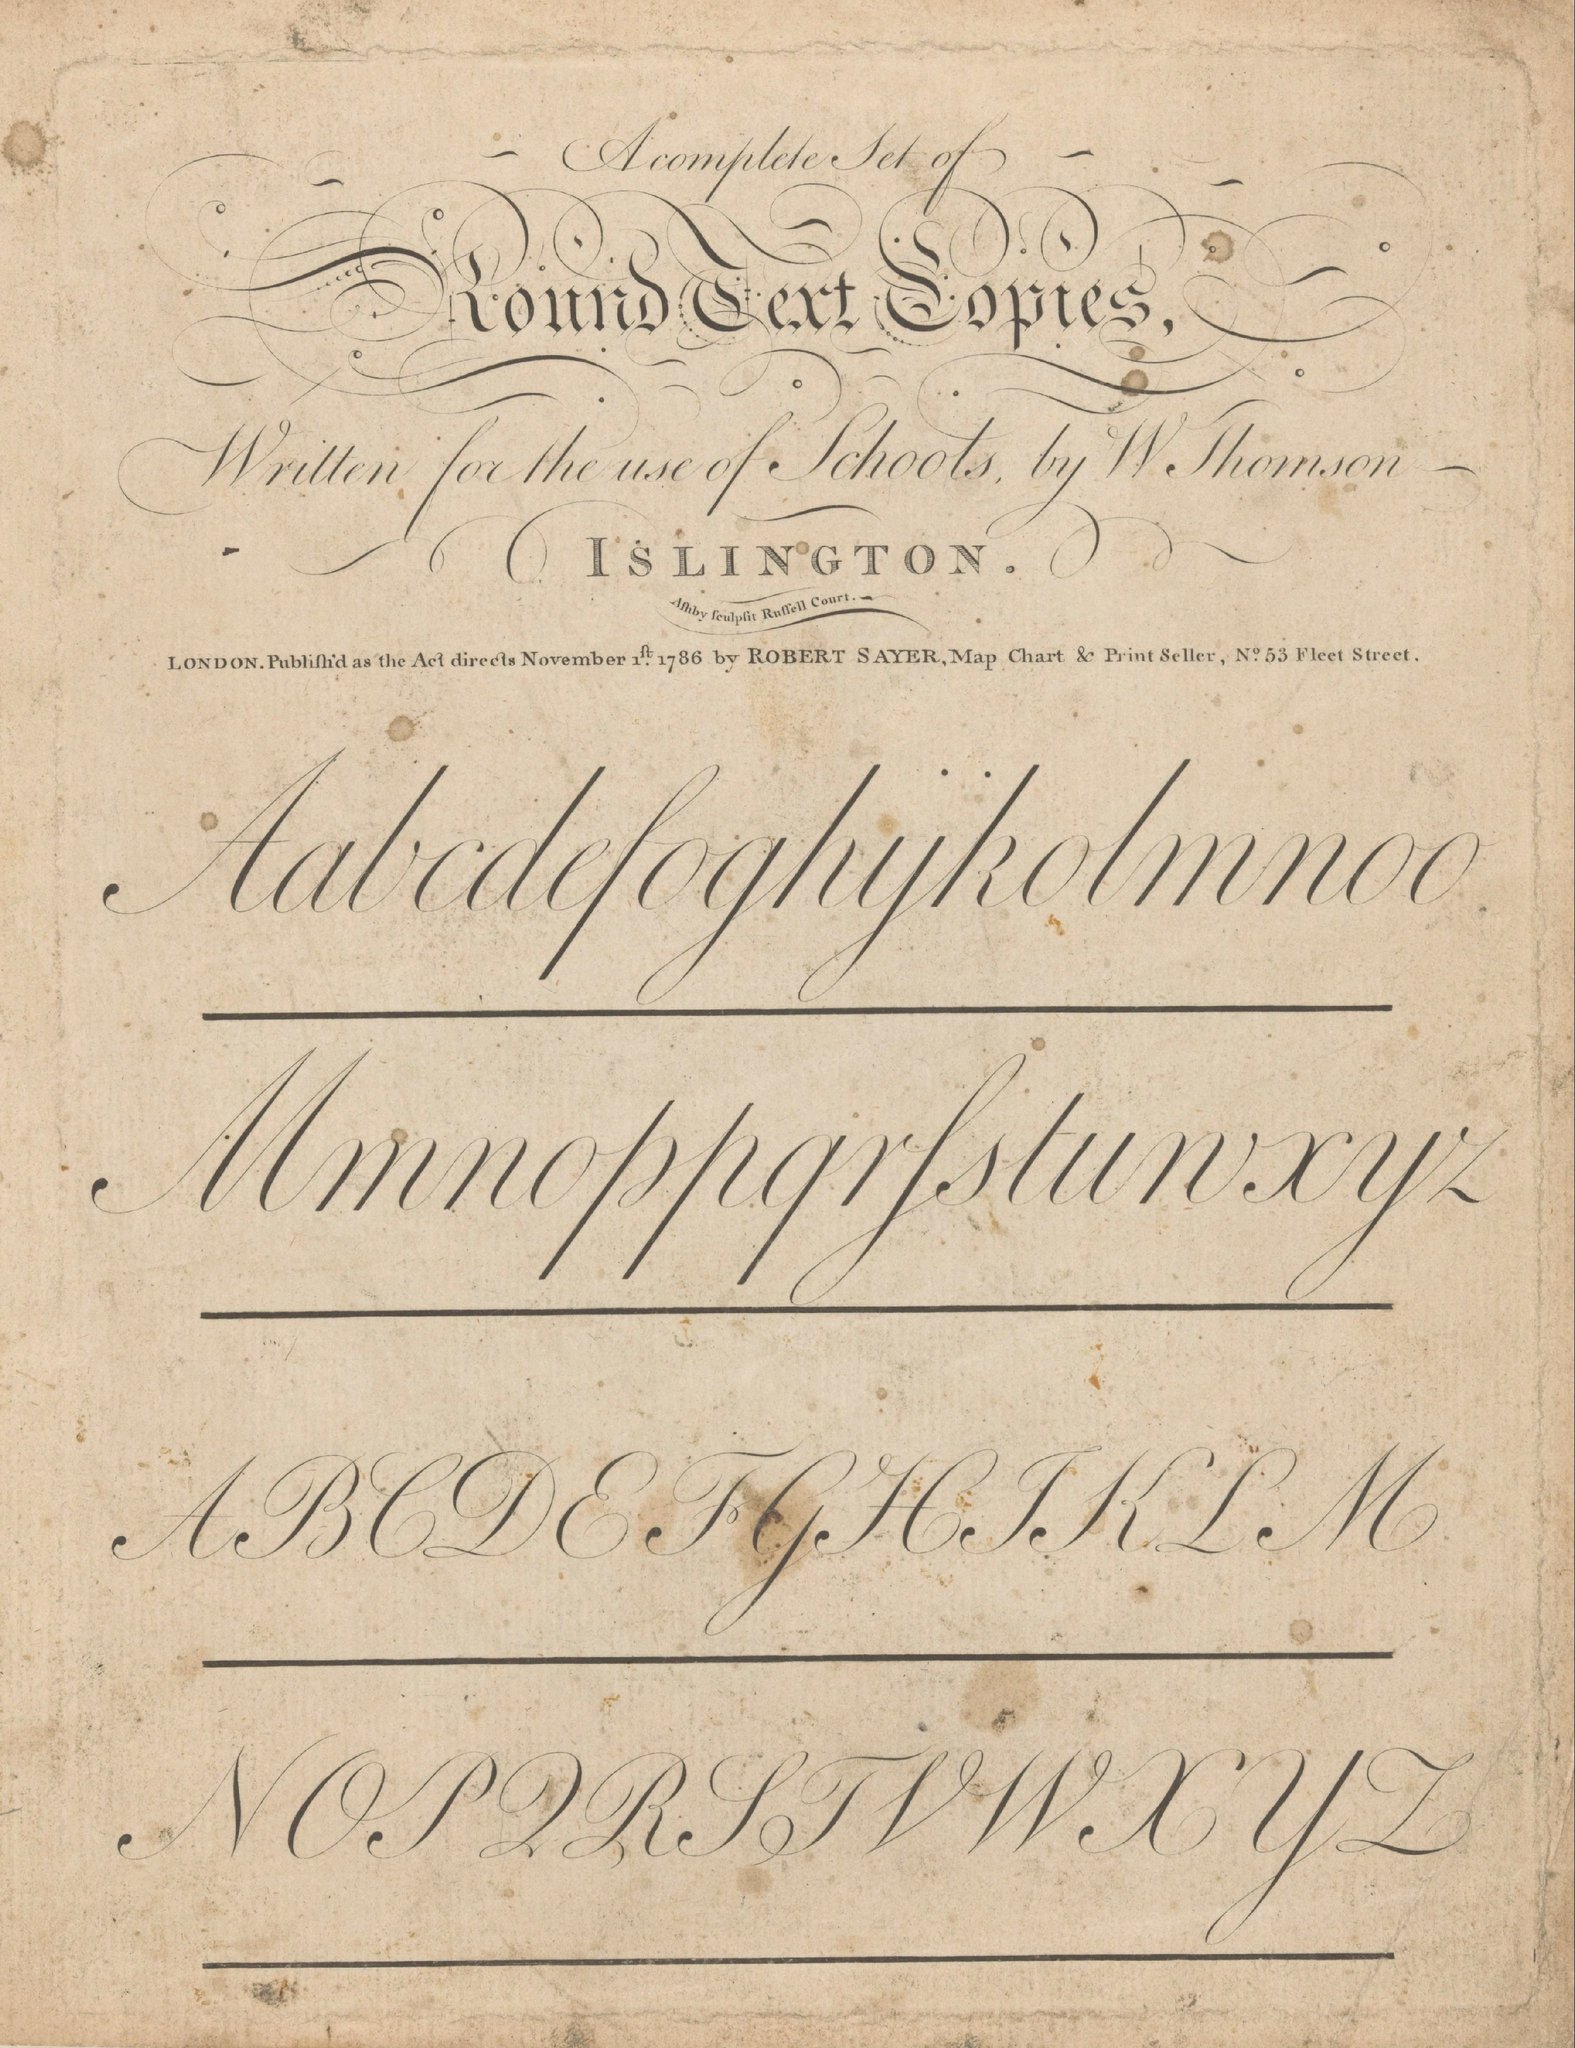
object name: print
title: Lettervoorbeelden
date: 1786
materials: paper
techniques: engraving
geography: london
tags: letters, alphabet, script, numerals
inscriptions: collector's mark: Lugt 2228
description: Het alfabet in kleine letters en kapitalen.